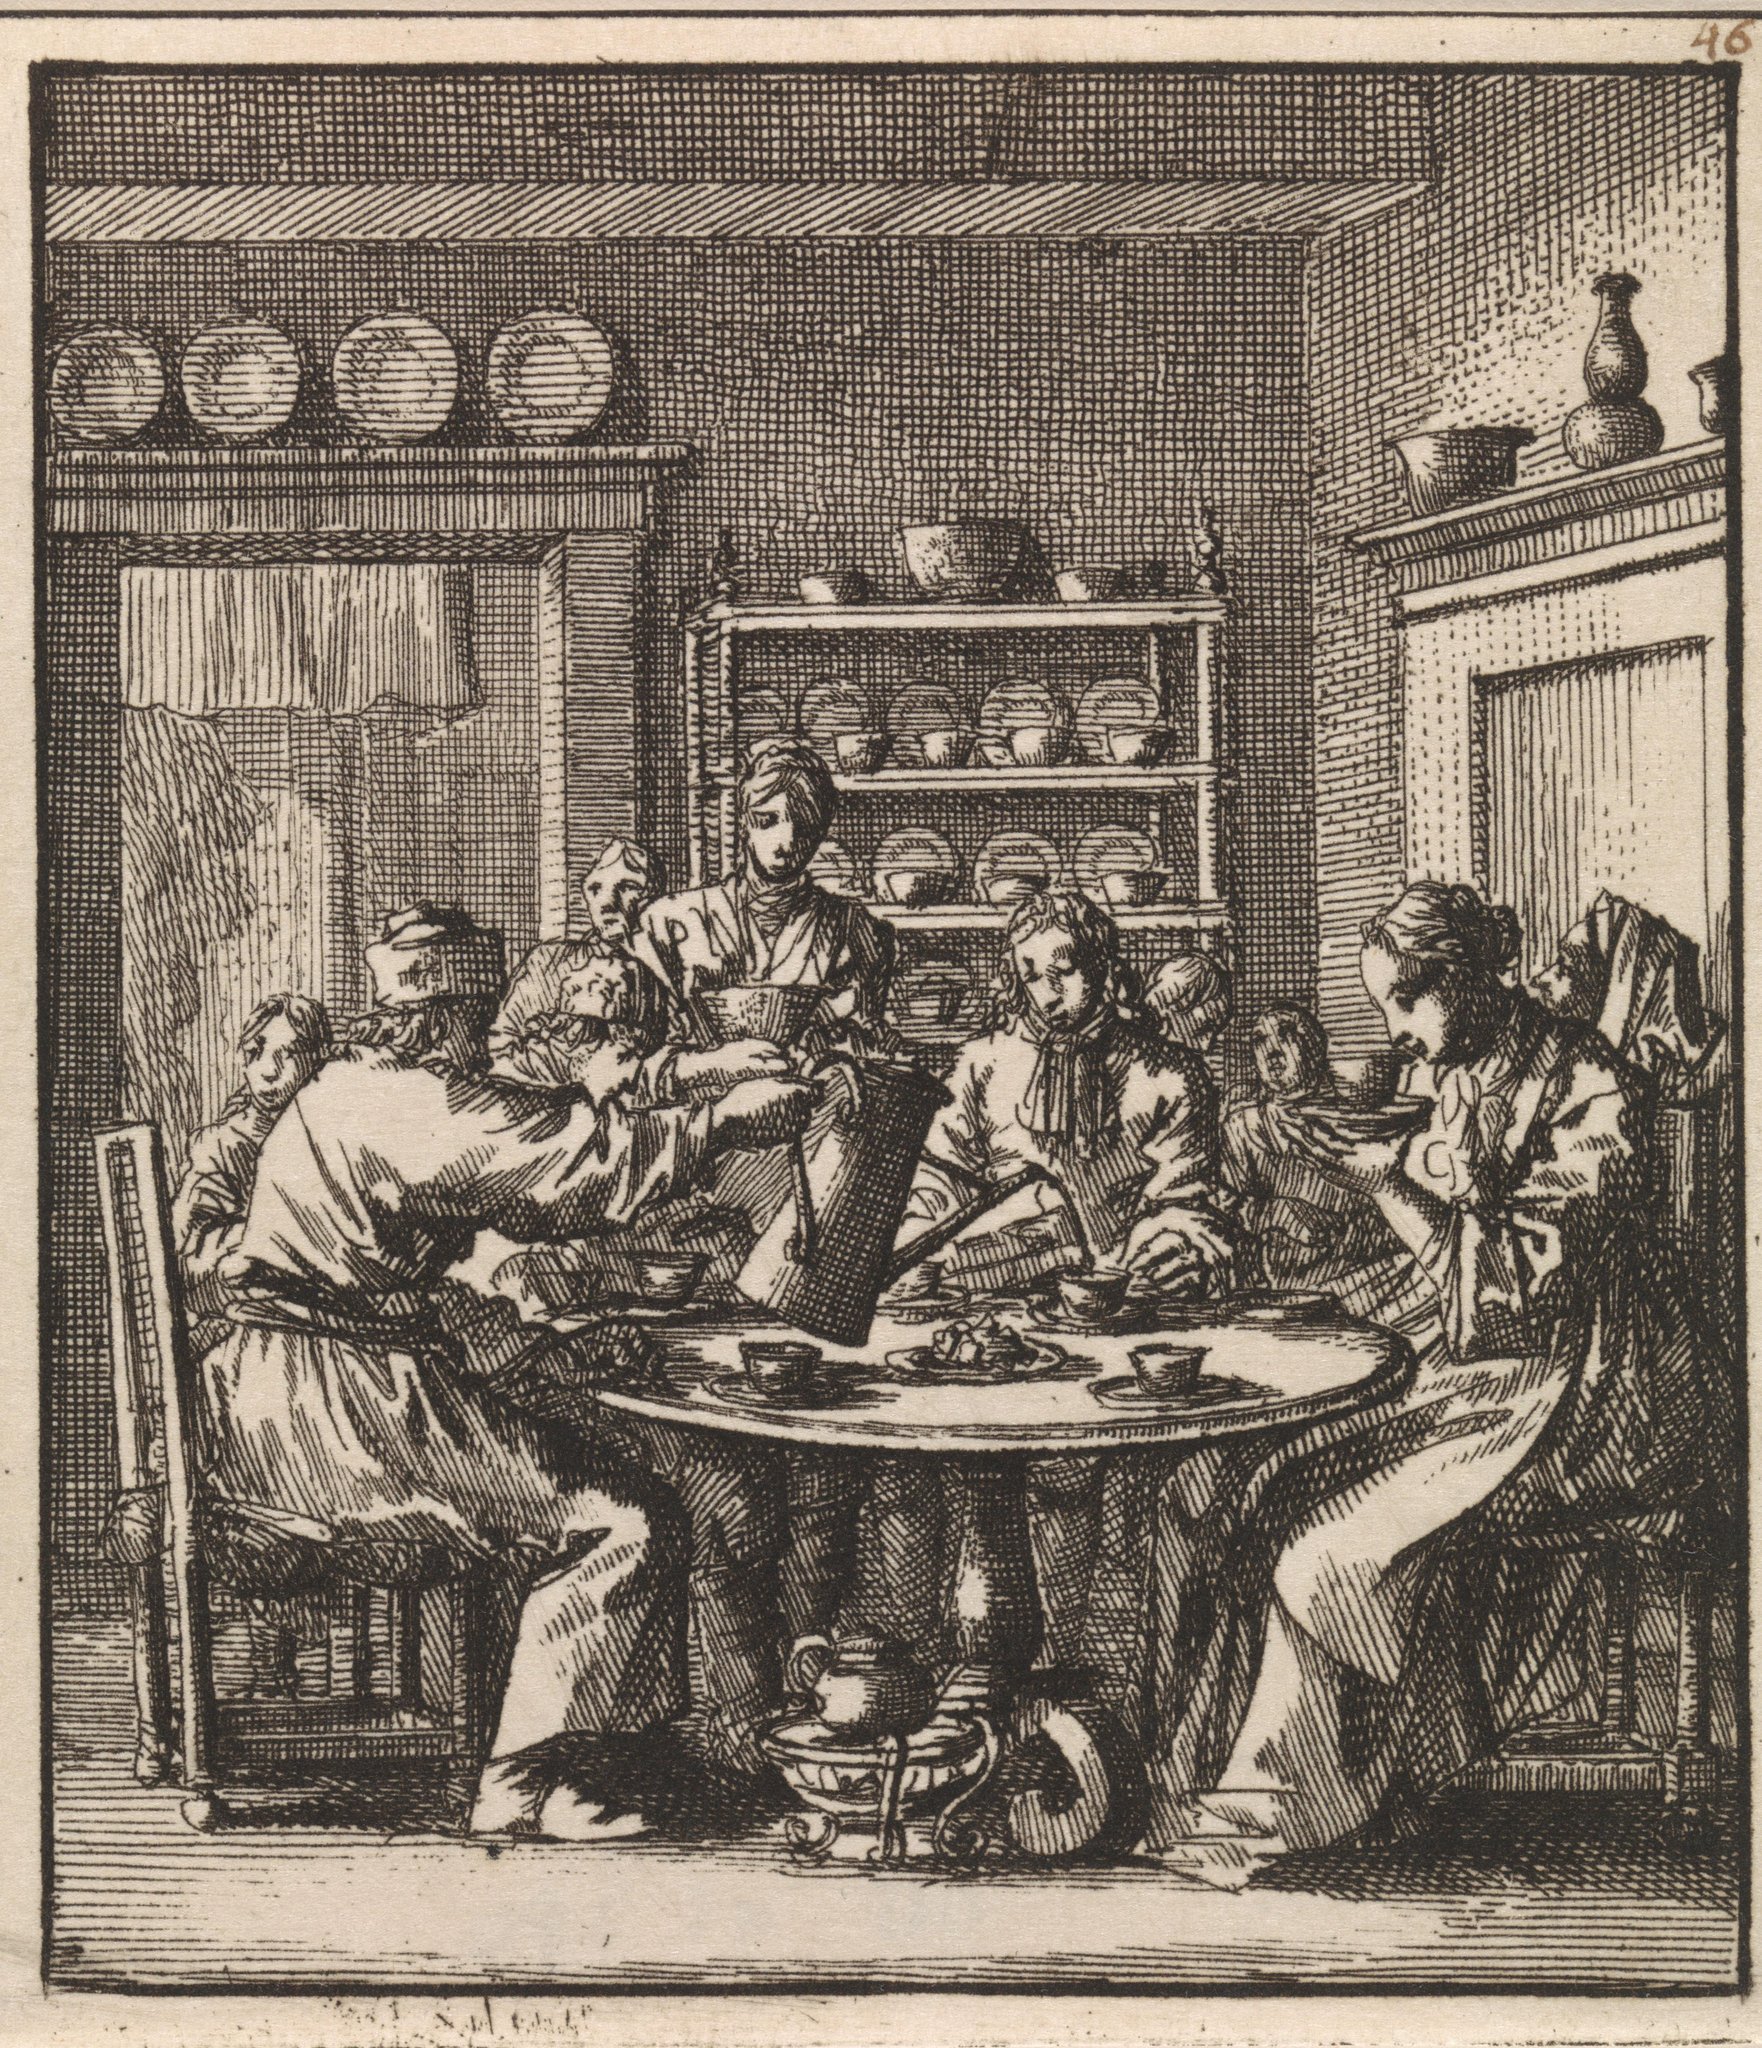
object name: print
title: Aan een tafel zit een gezelschap koffie te drinken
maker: jan luyken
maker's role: draughtsman, print maker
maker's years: 1649-1712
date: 1711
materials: paper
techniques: etching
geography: amsterdam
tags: cup of coffee, tea- and coffee-service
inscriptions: collector's mark: Lugt 2228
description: Proefdruk van illustratie voor: Luyken, Jan. Het leerzaam huisraad, vertoond in vyftig konstige figuuren, met godlyke spreuken en stichtelyke verzen: Pieter Arentsz. II (wed.) en Cornelis van der Sys, 1711, p. 160.